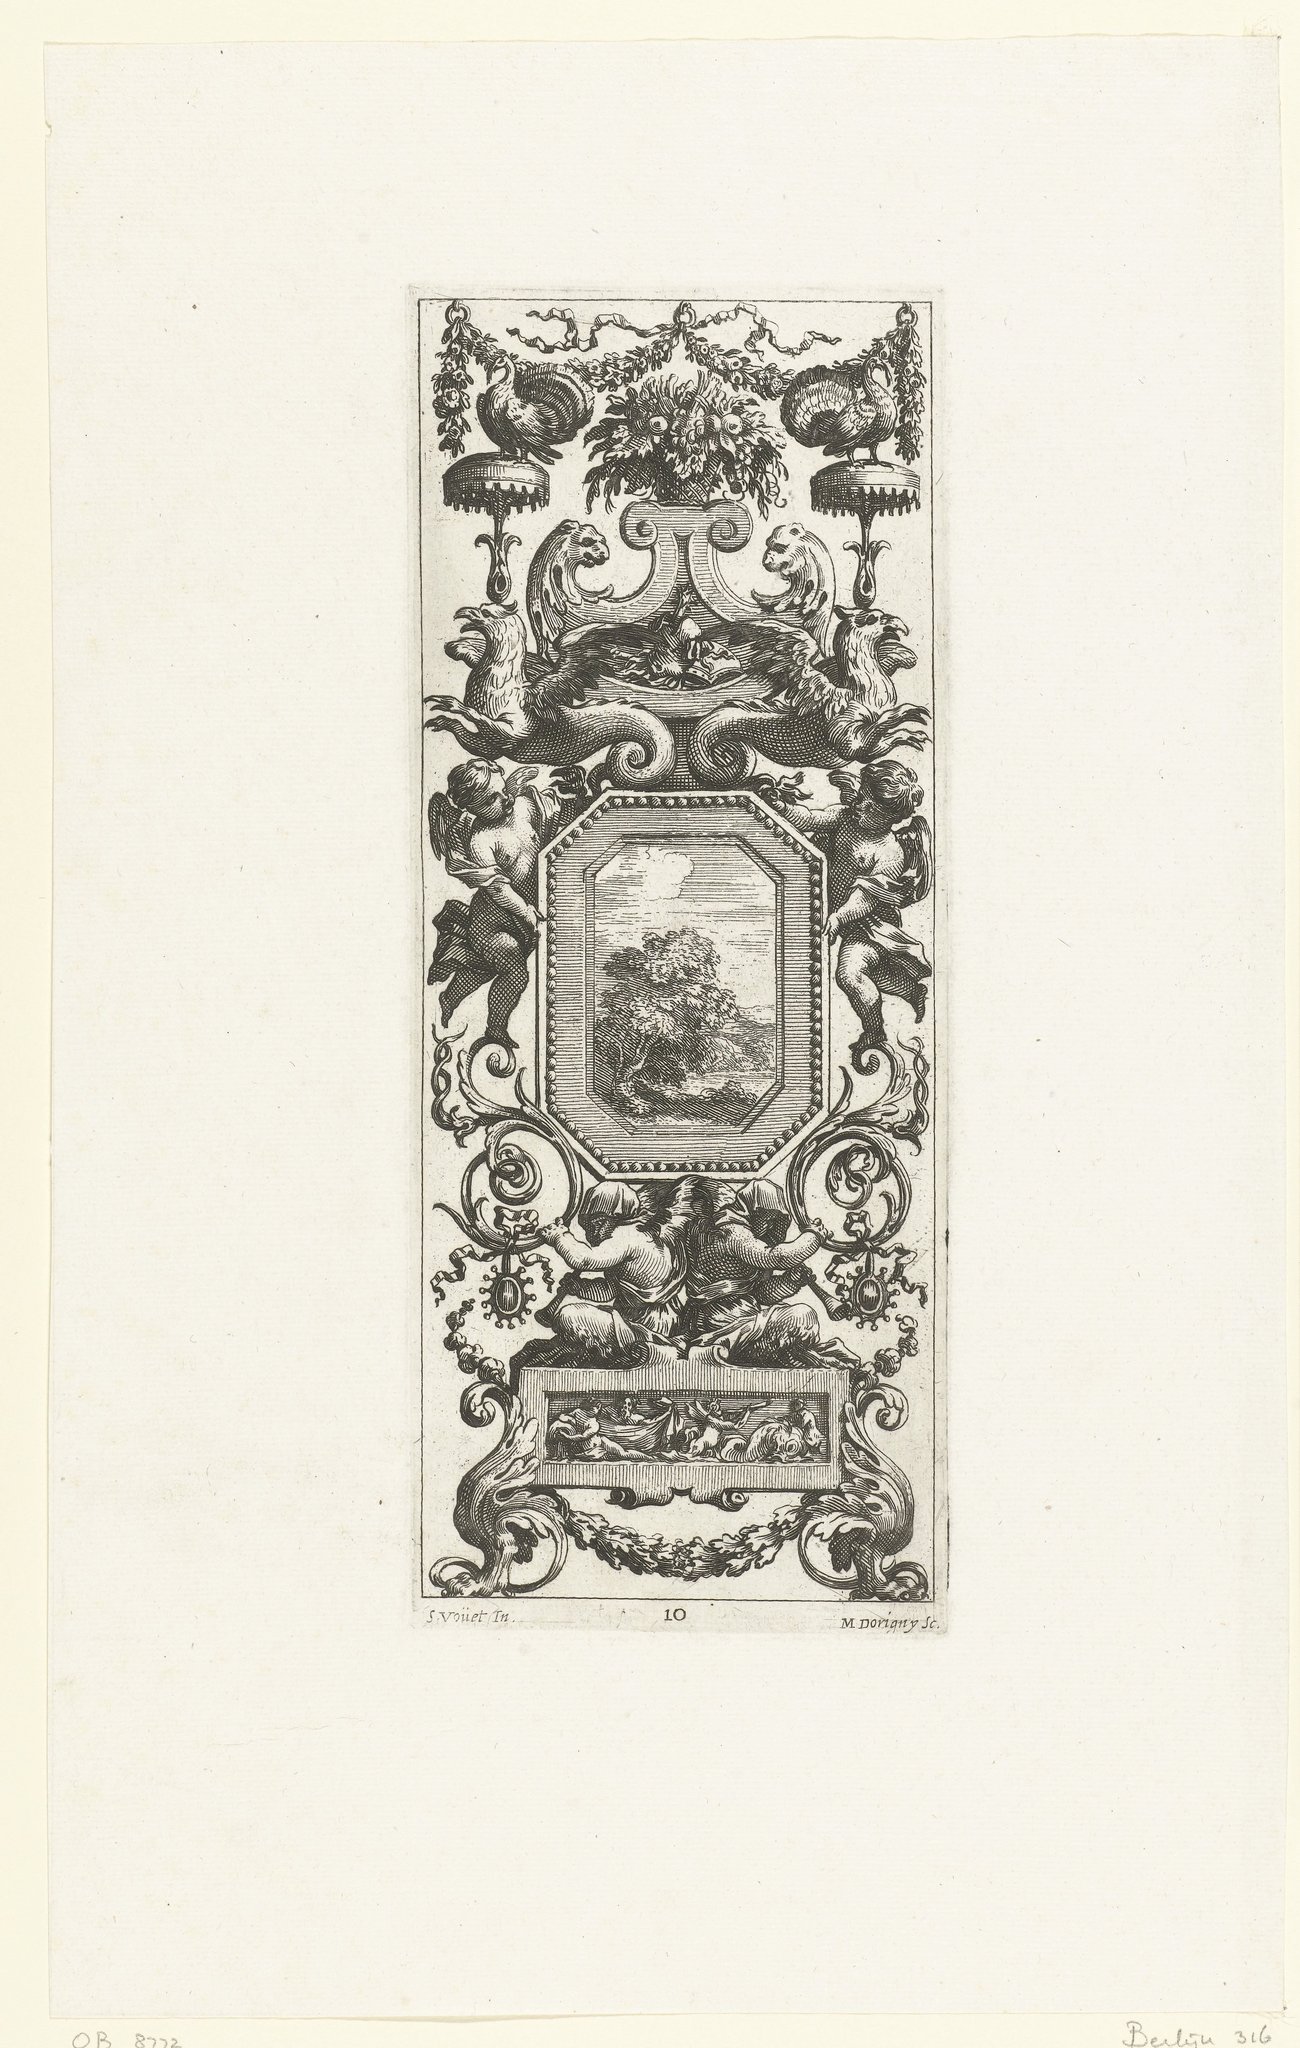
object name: ornament print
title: Muurpaneel met twee saterkinderen onder achthoekige lijst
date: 1647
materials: paper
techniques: engraving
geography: paris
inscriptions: collector's mark: Lugt 240